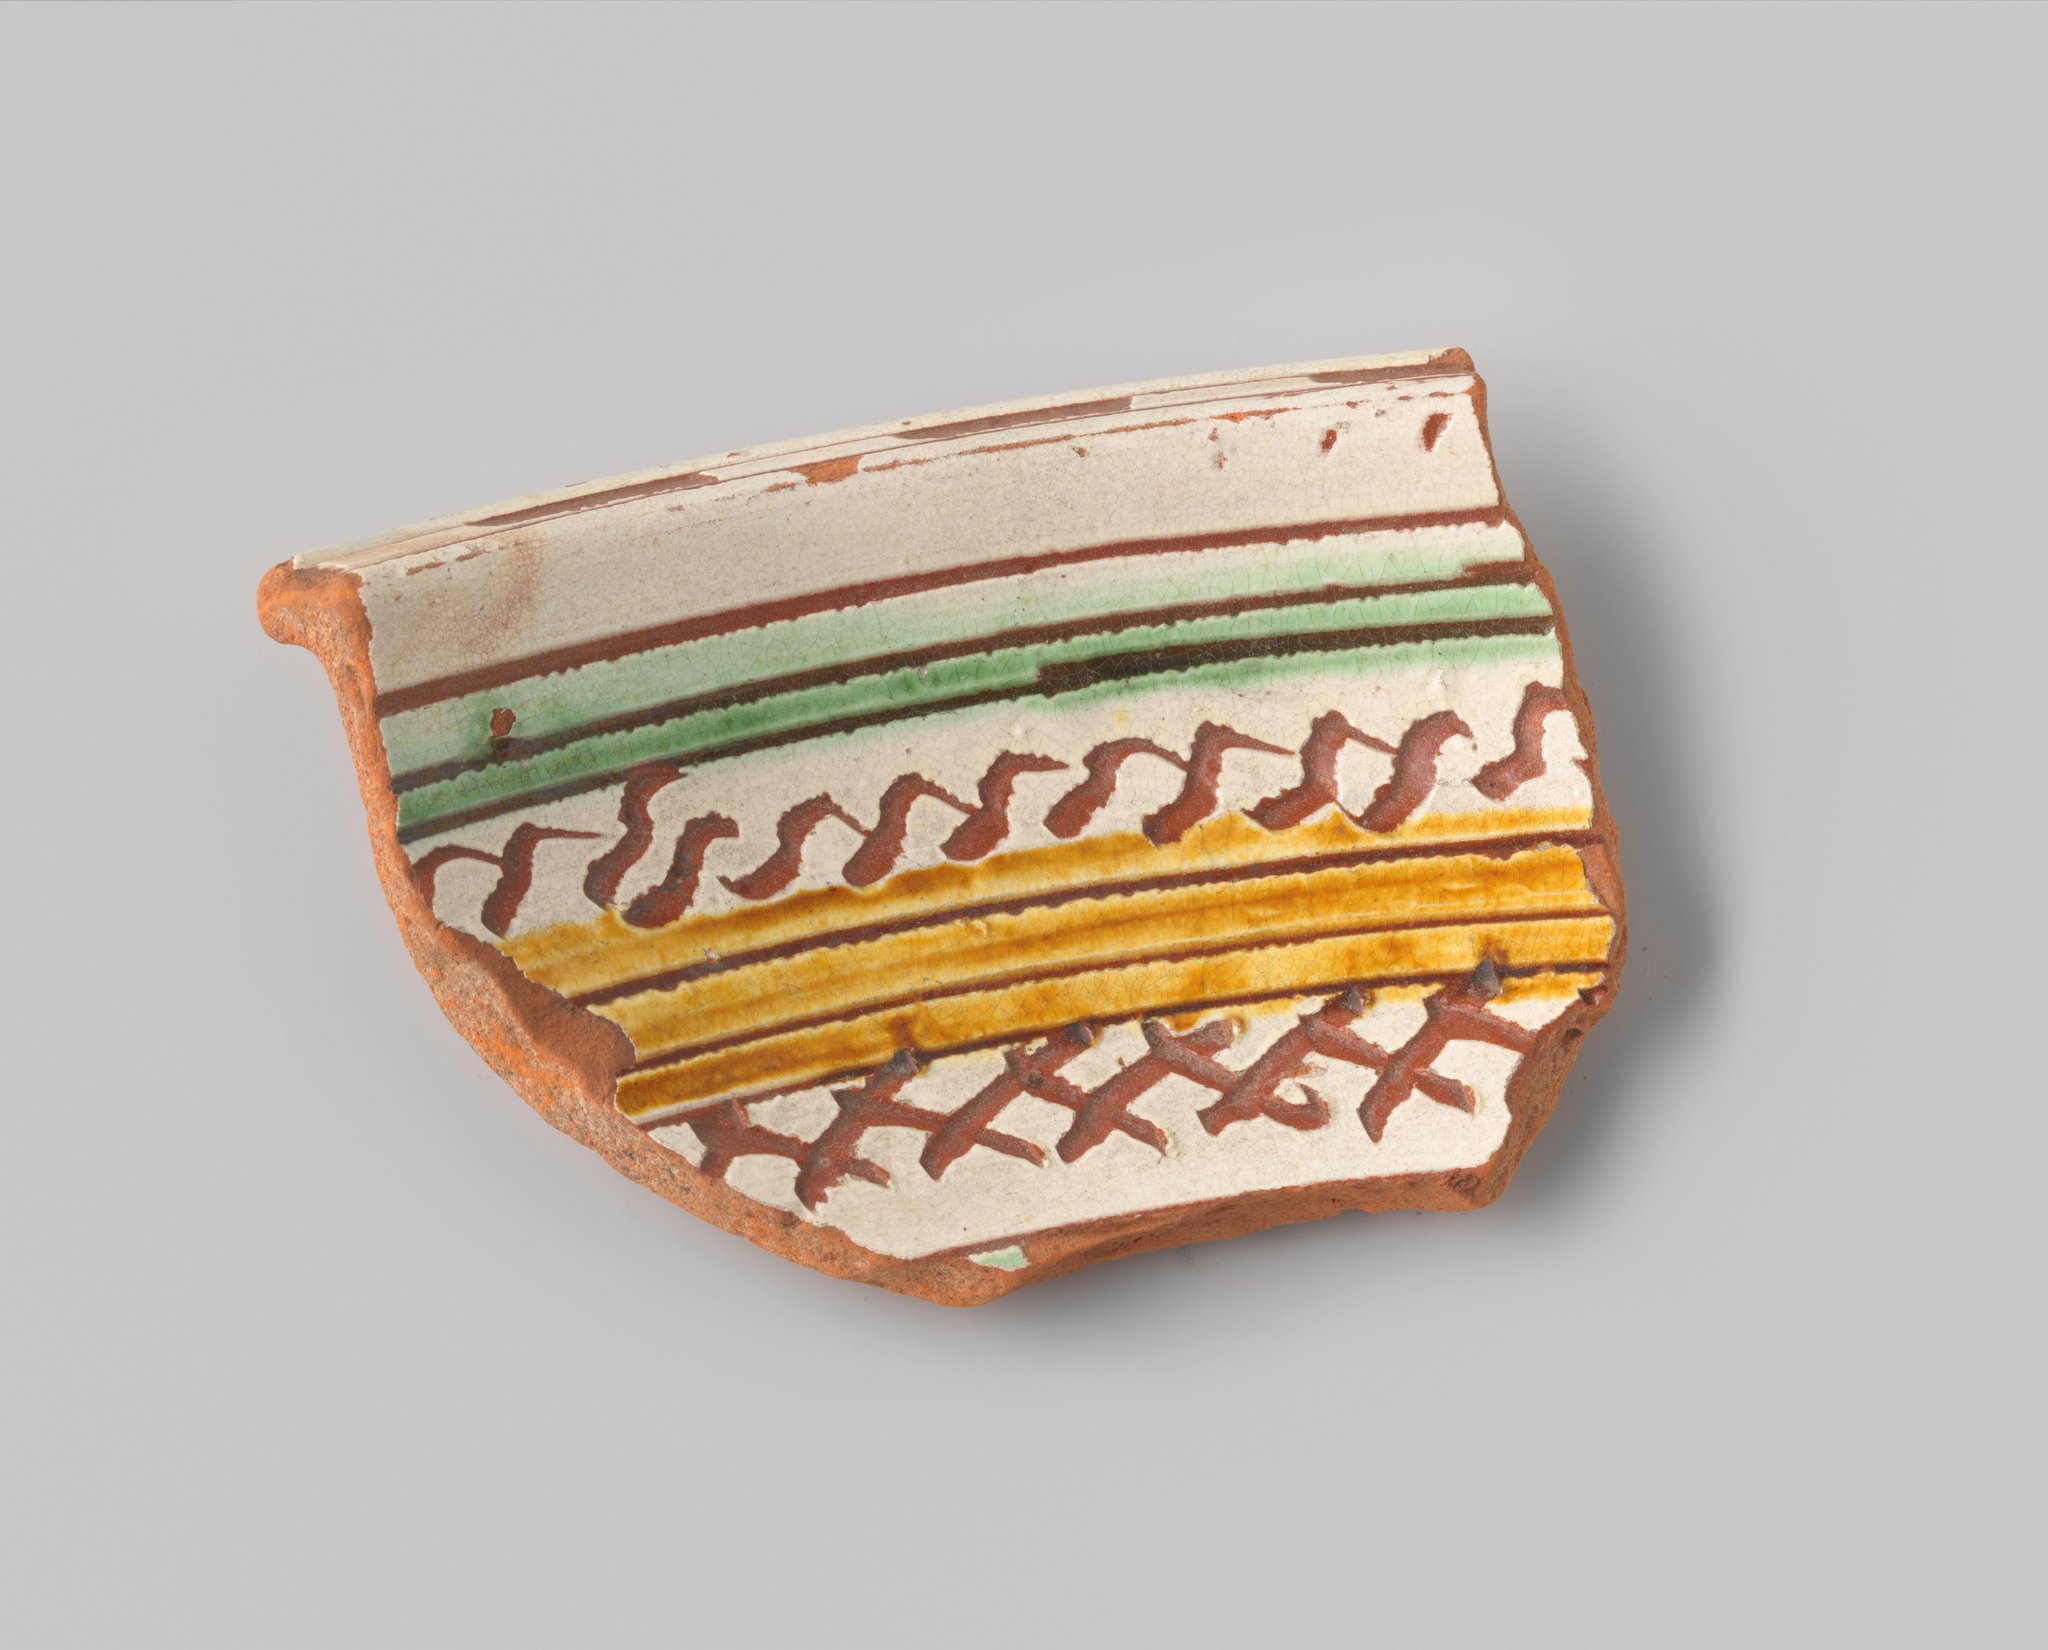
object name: sherd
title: Fragment met rode scherf, aan de voorzijde voorzien van florale vormen en banen in sgraffito-techniek met oker en groen glazuur op een witte ondergrond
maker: Anonymous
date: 1200-1899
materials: earthenware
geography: italy